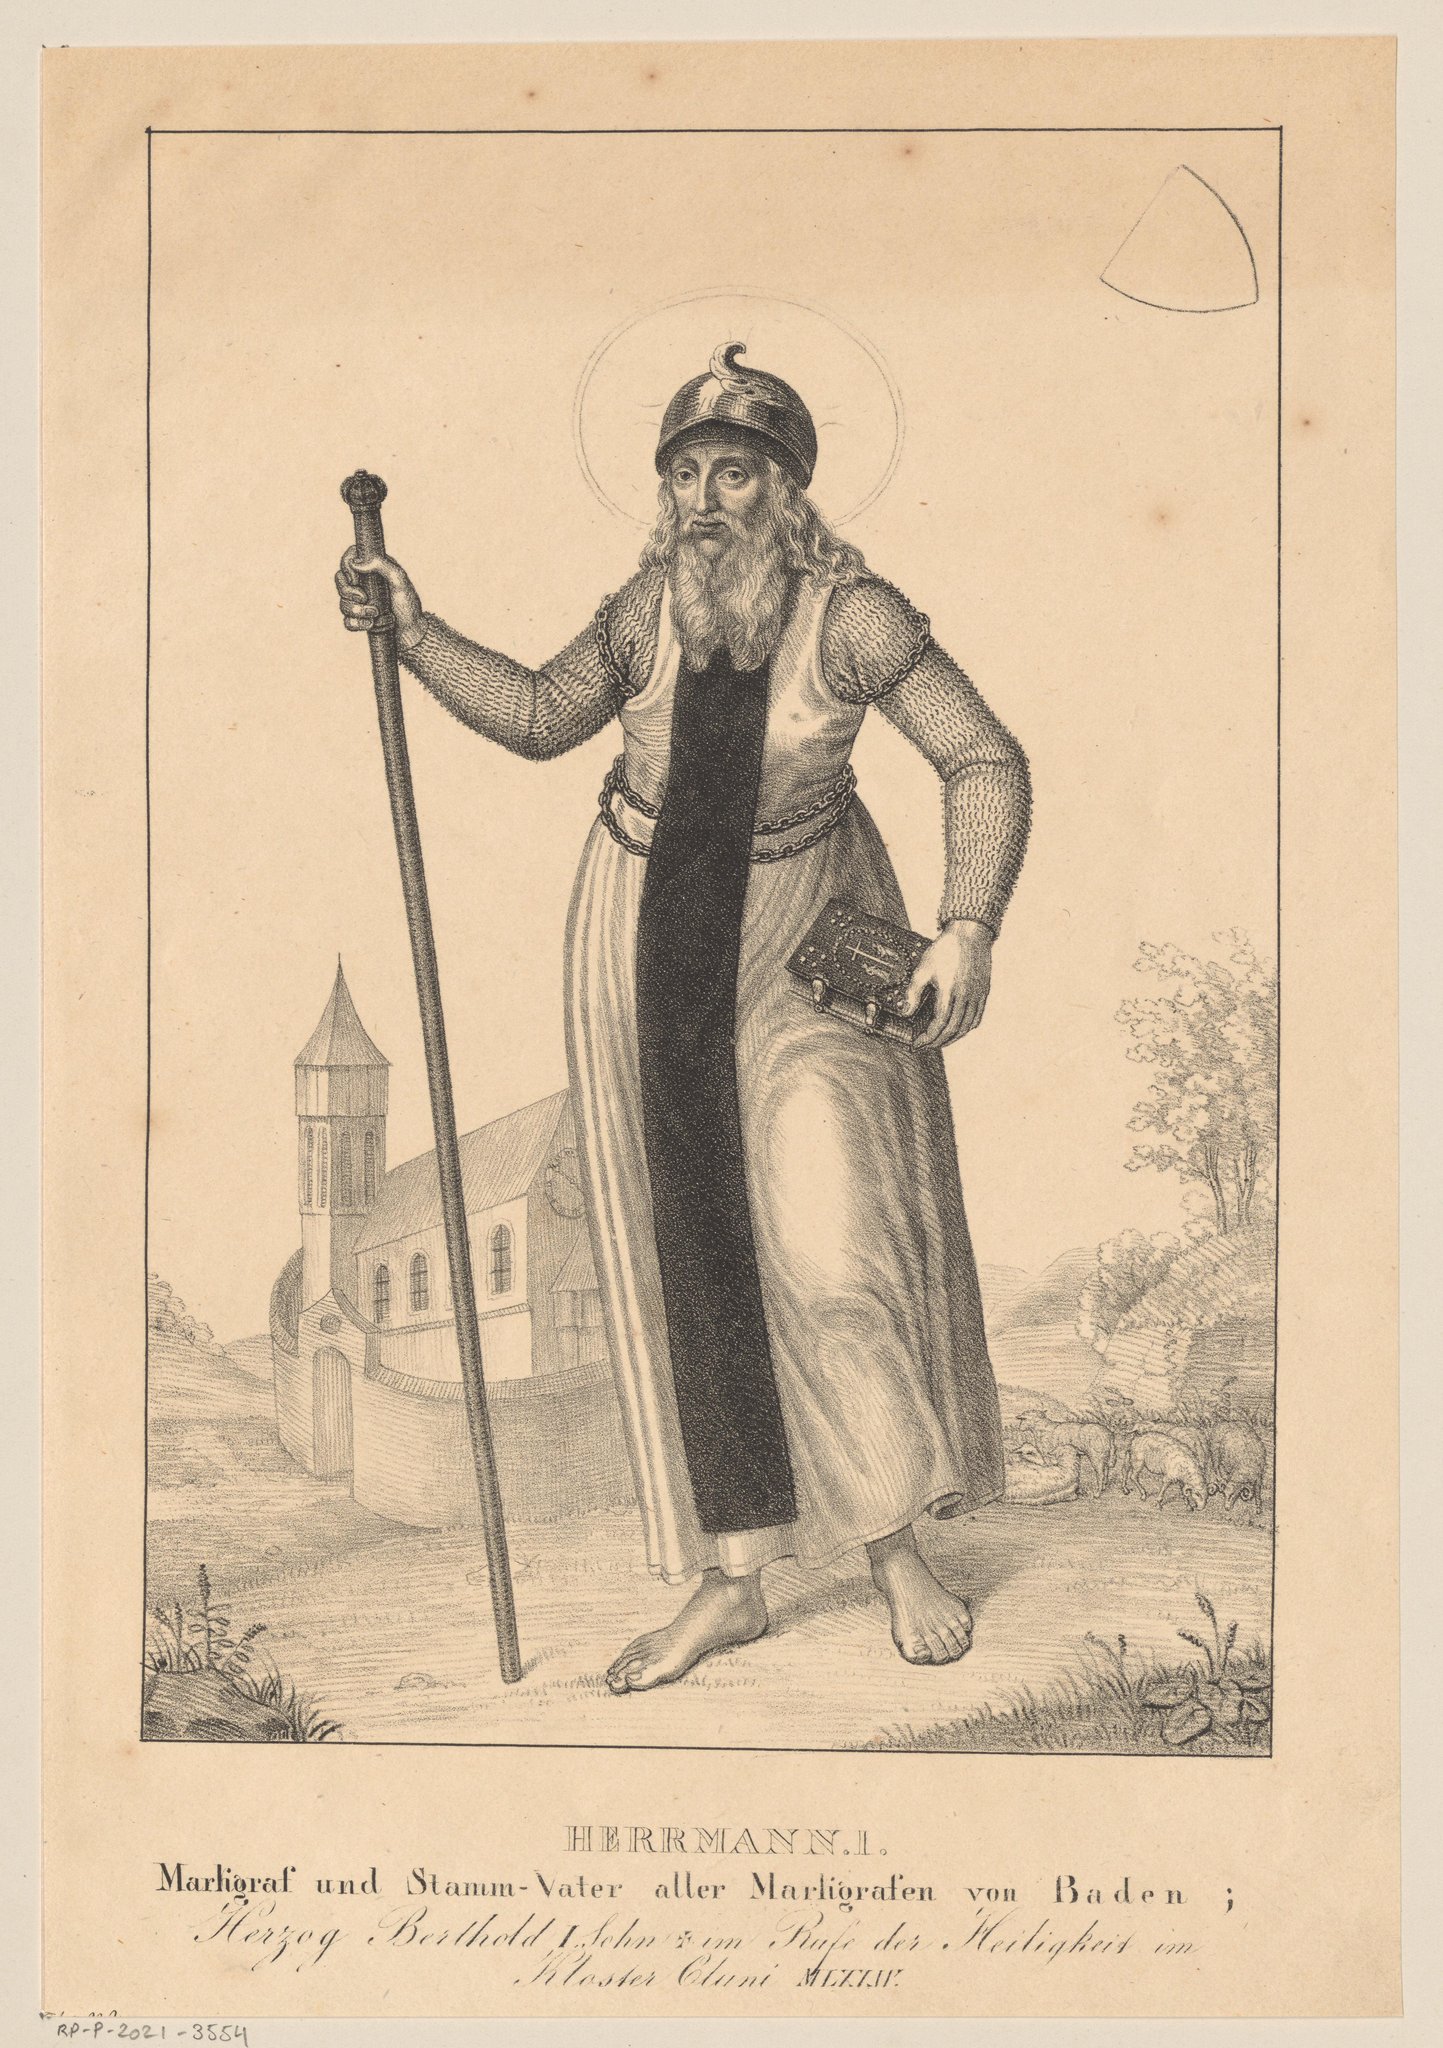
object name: print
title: Portret van Herman I van Baden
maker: Anonymous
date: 1825-1874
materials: paper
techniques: lithograph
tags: historical persons, saints, book